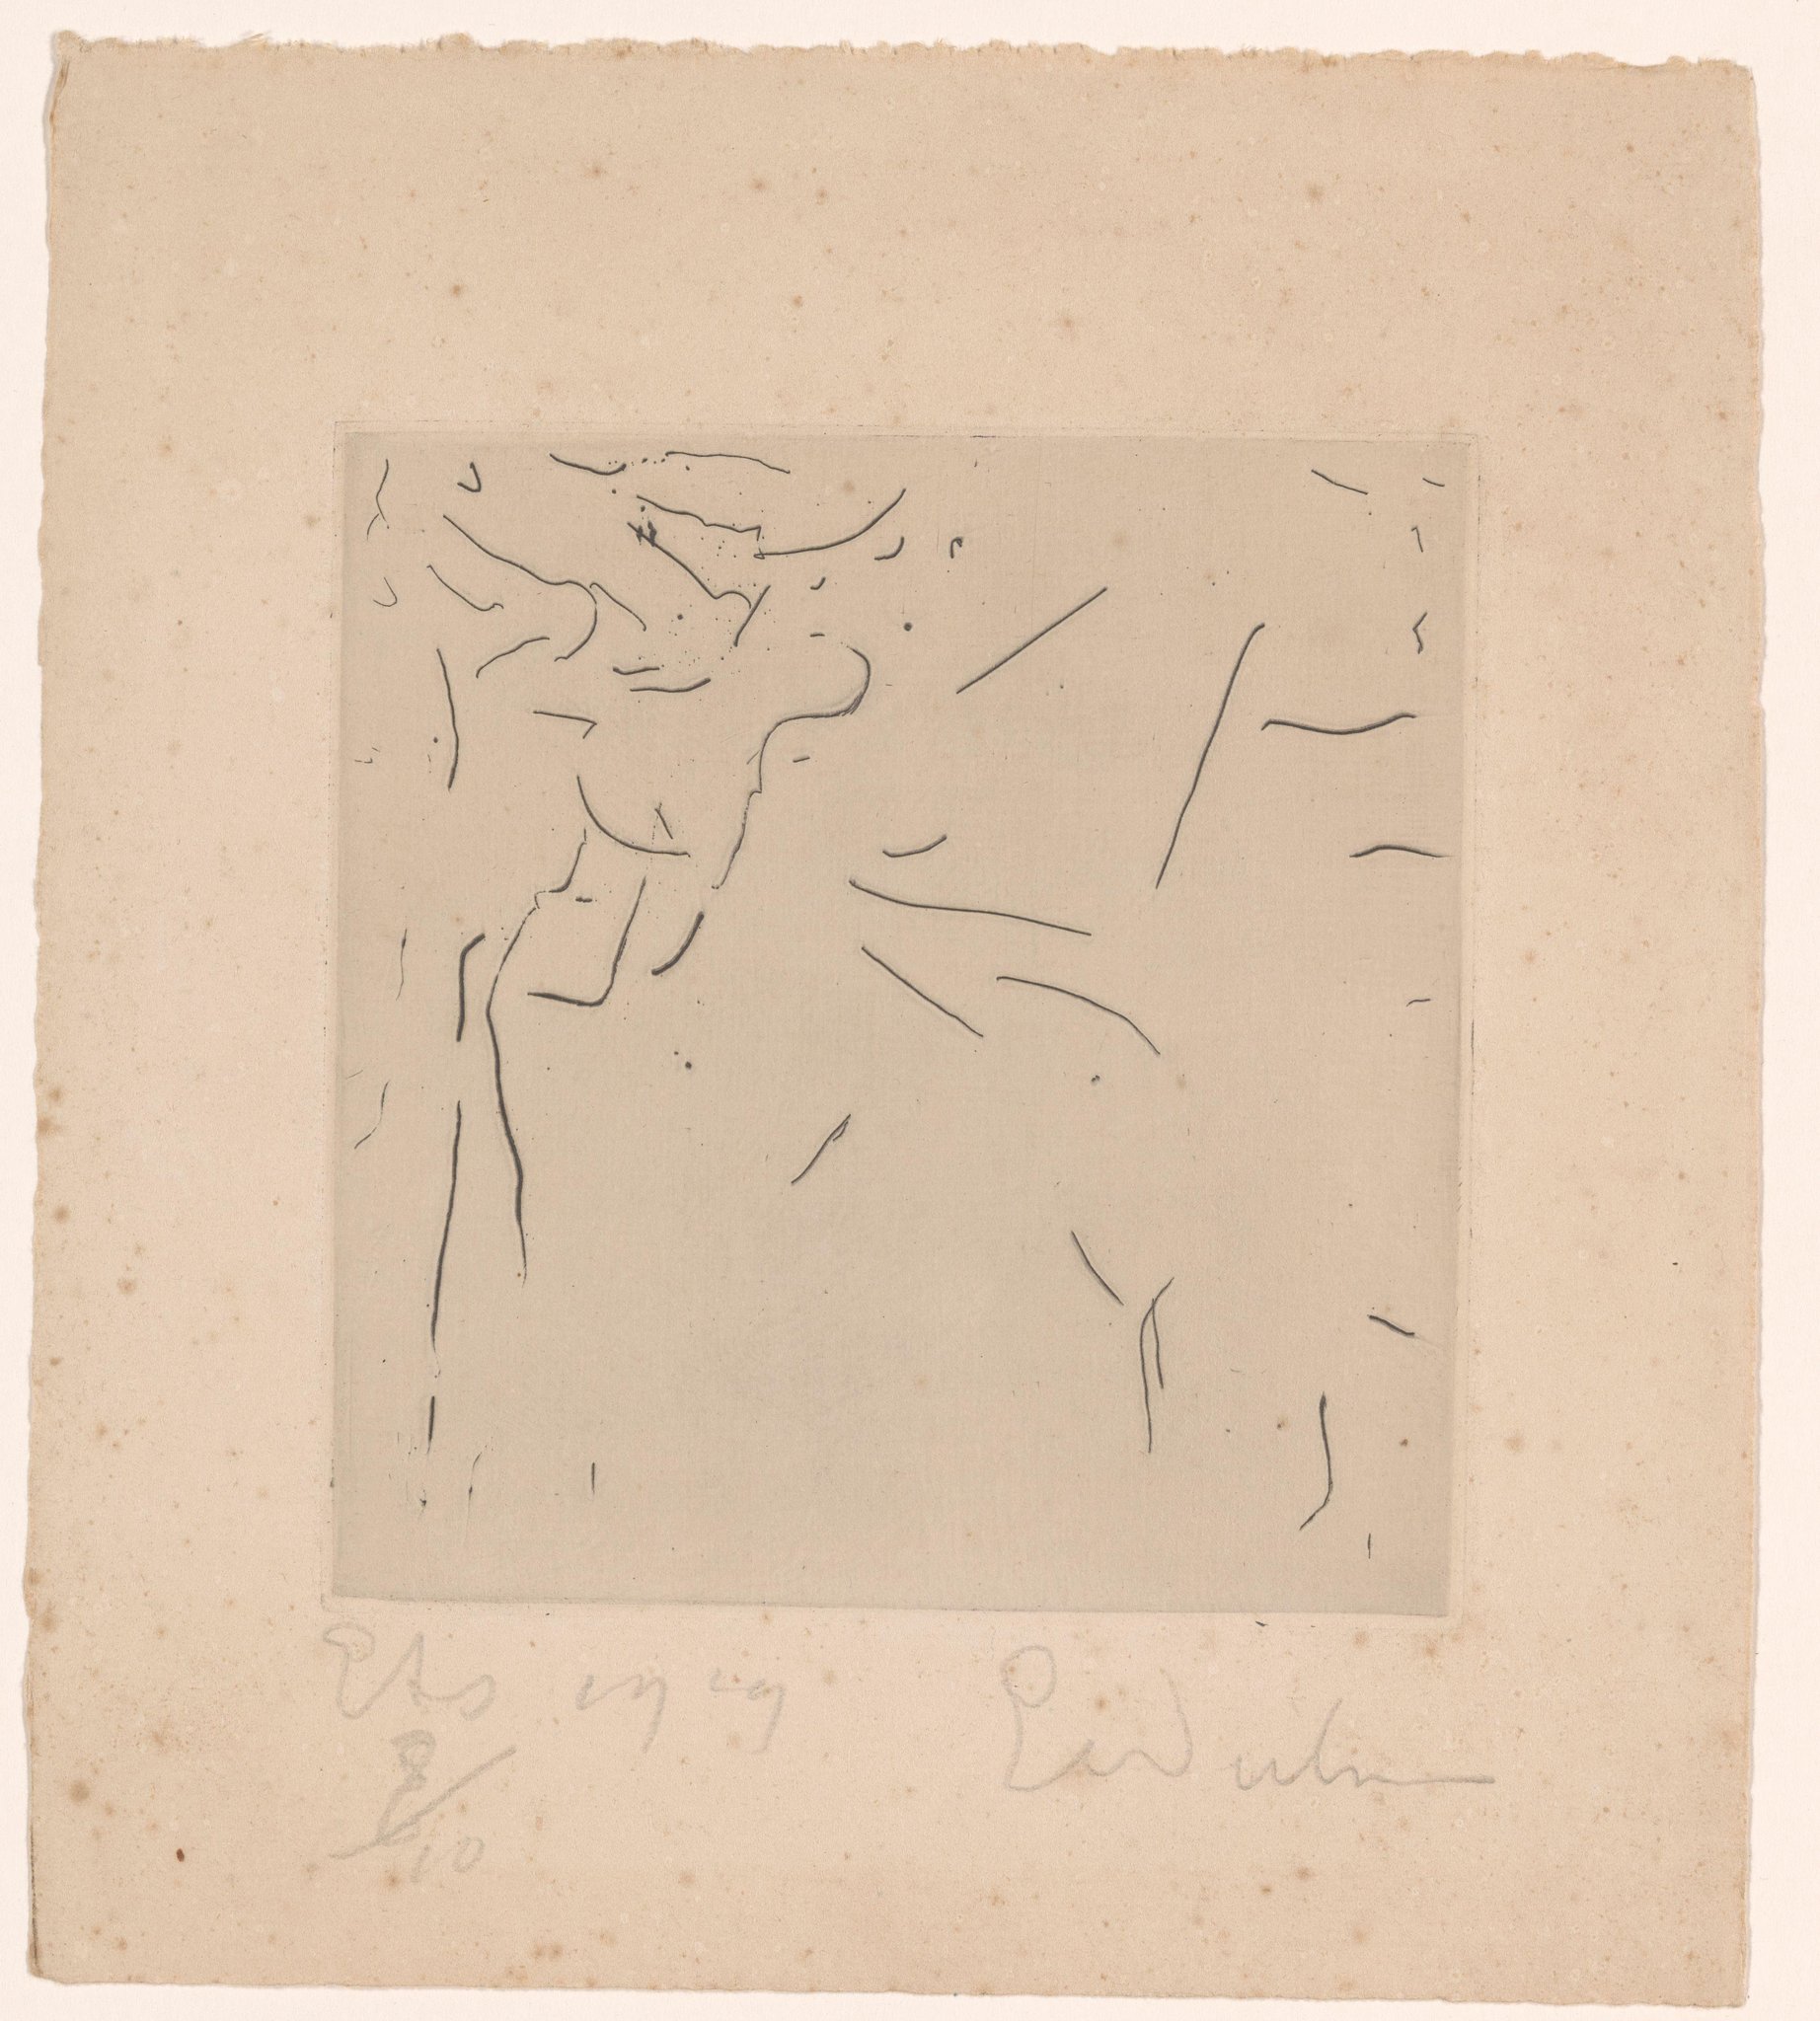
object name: print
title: Abstracte compositie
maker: erich wichmann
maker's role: print maker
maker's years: 1890-1929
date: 1919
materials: paper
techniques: etching, intaglio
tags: abstract, non-representational art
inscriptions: collector's mark: Lugt 2228